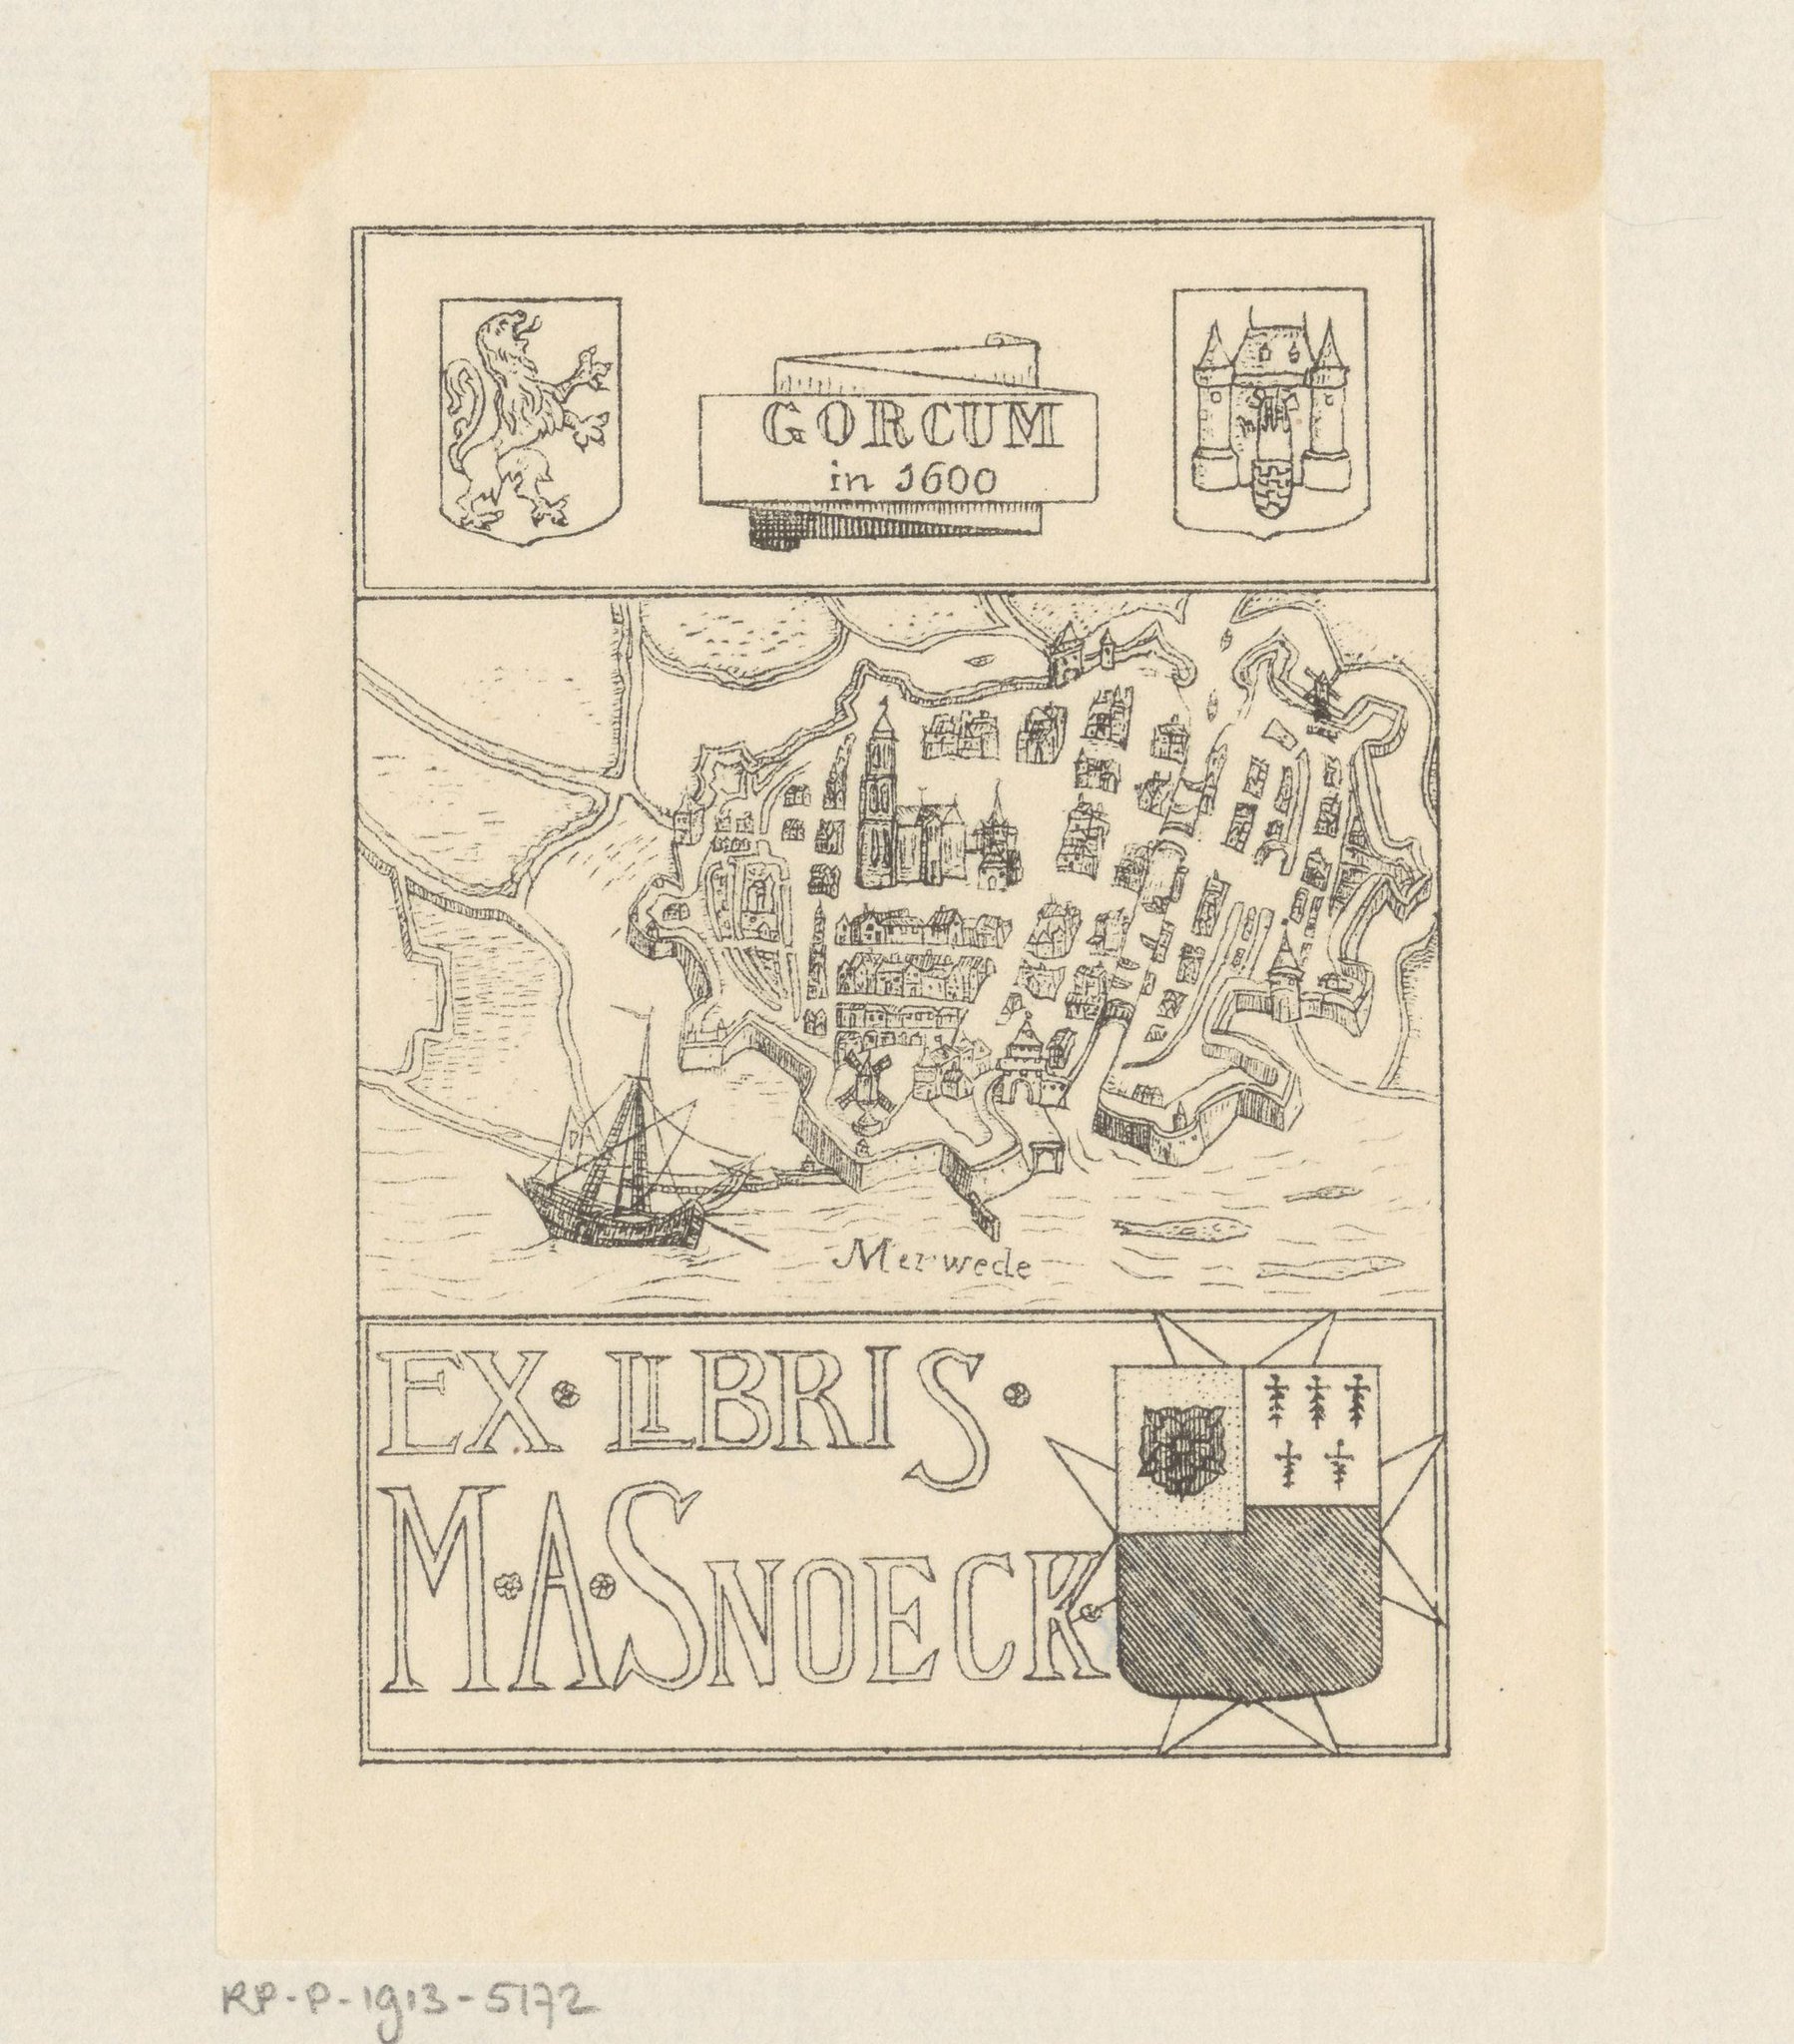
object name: bookplate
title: Ex libris van M.A. Snoeck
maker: Anonymous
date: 1870-1913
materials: paper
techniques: printing block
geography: netherlands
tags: maps, atlases, armorial bearing, heraldry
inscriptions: collector's mark: Lugt 2760, collector's mark: Lugt 2233